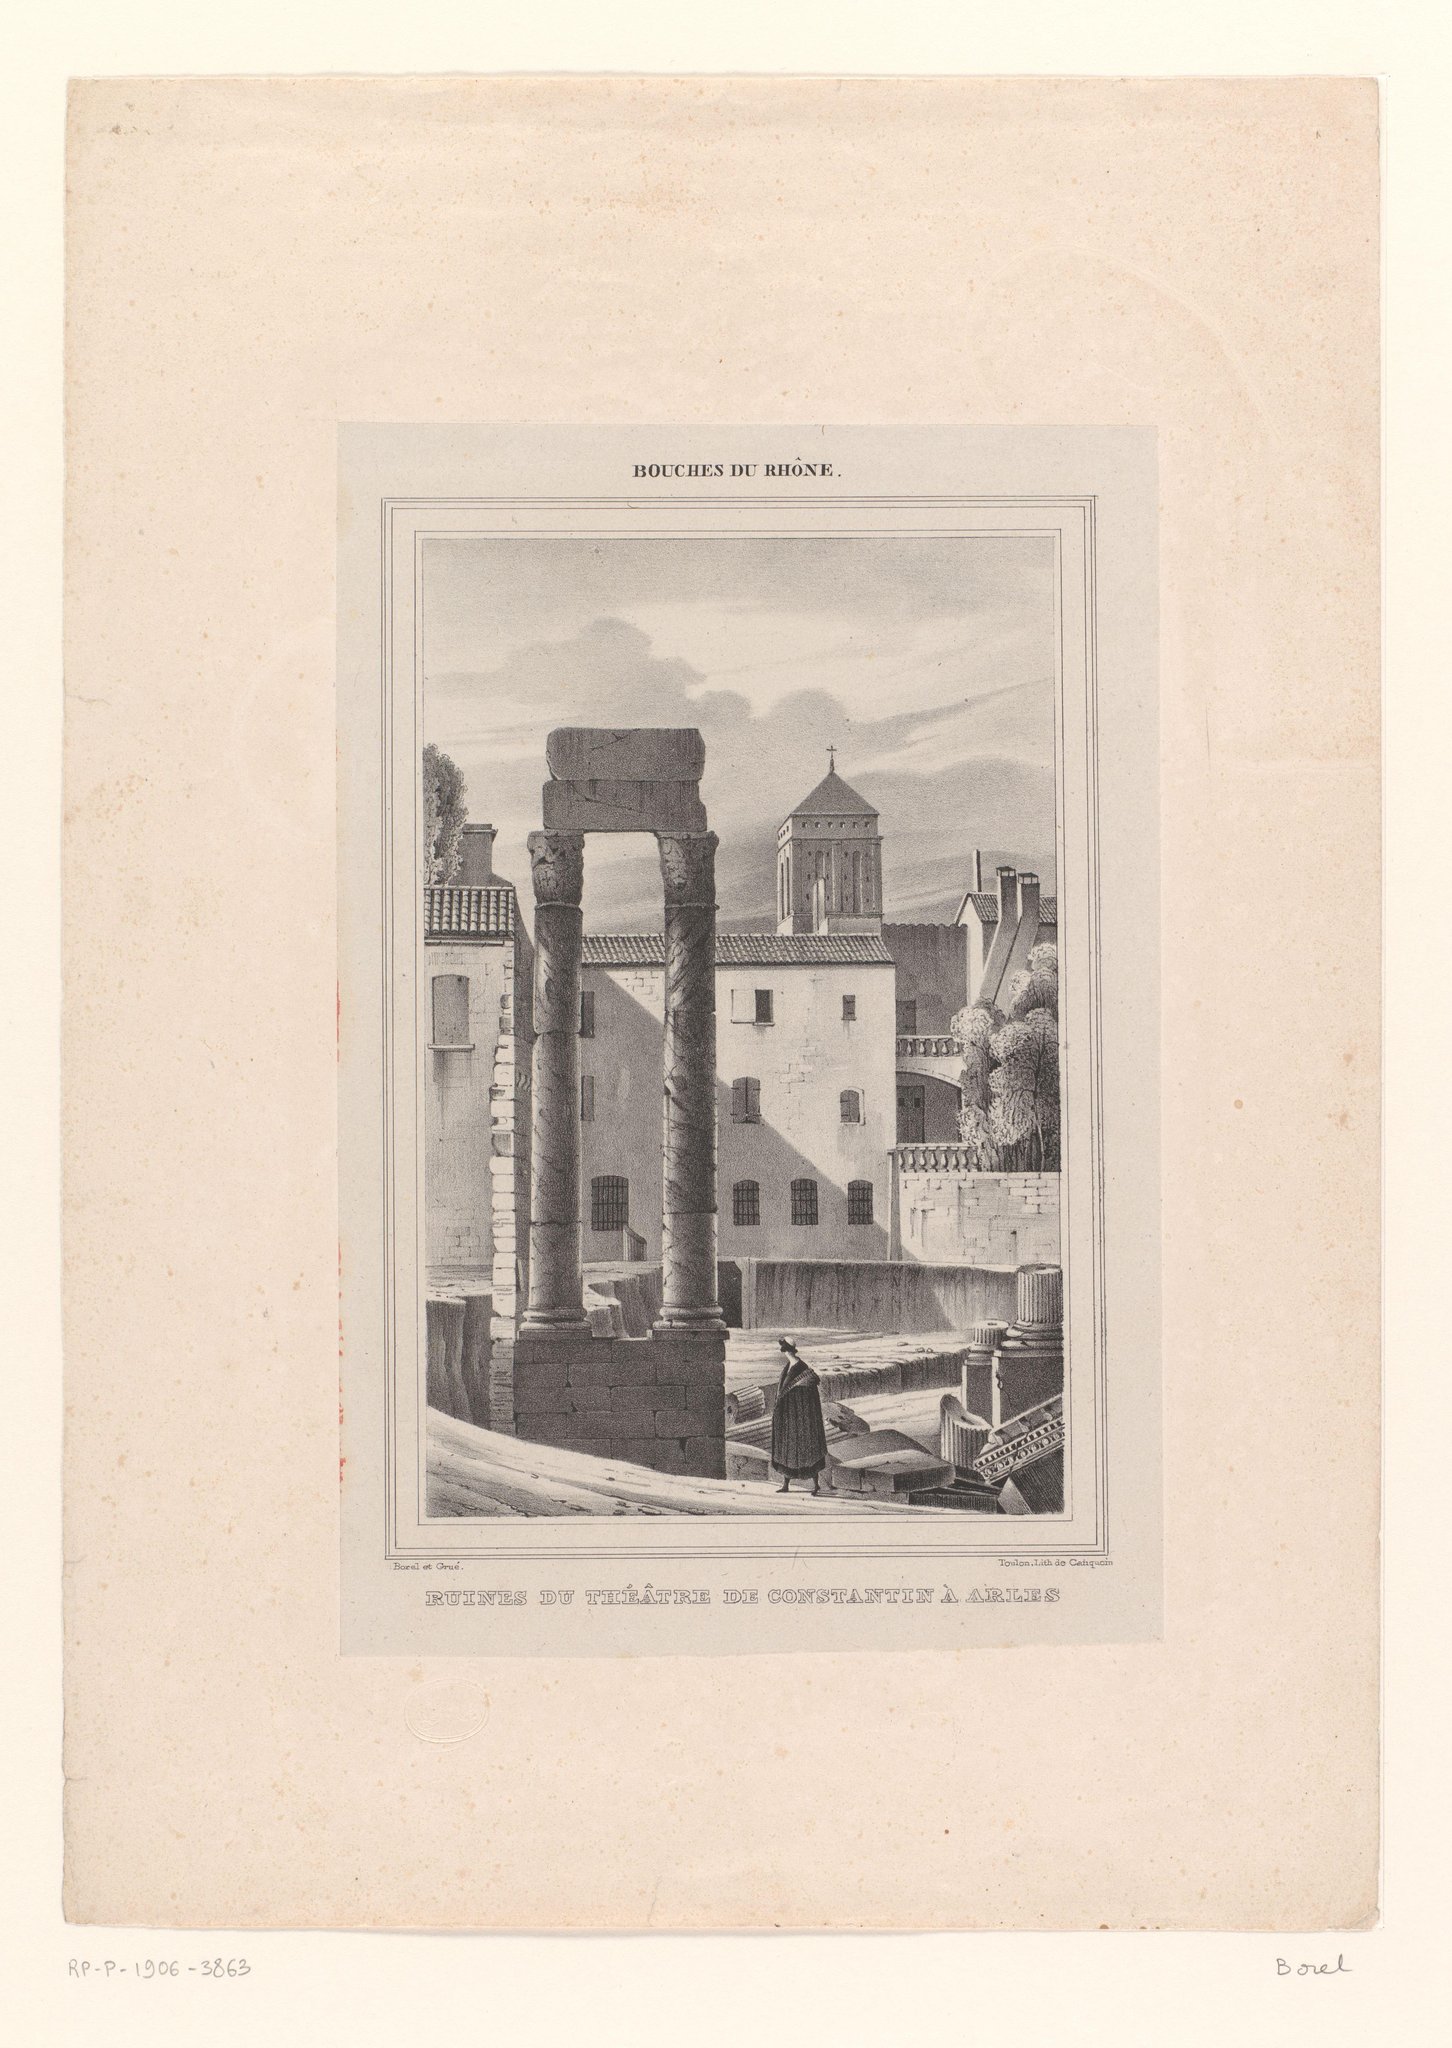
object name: print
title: Langs de oevers van de Rhône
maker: canquoin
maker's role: lithograaf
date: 1832-1833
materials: paper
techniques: lithograph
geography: toulon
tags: ruin of a building ~ architecture, amphitheatre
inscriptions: collector's mark: Lugt 2228a, check stamp: ‘BG’